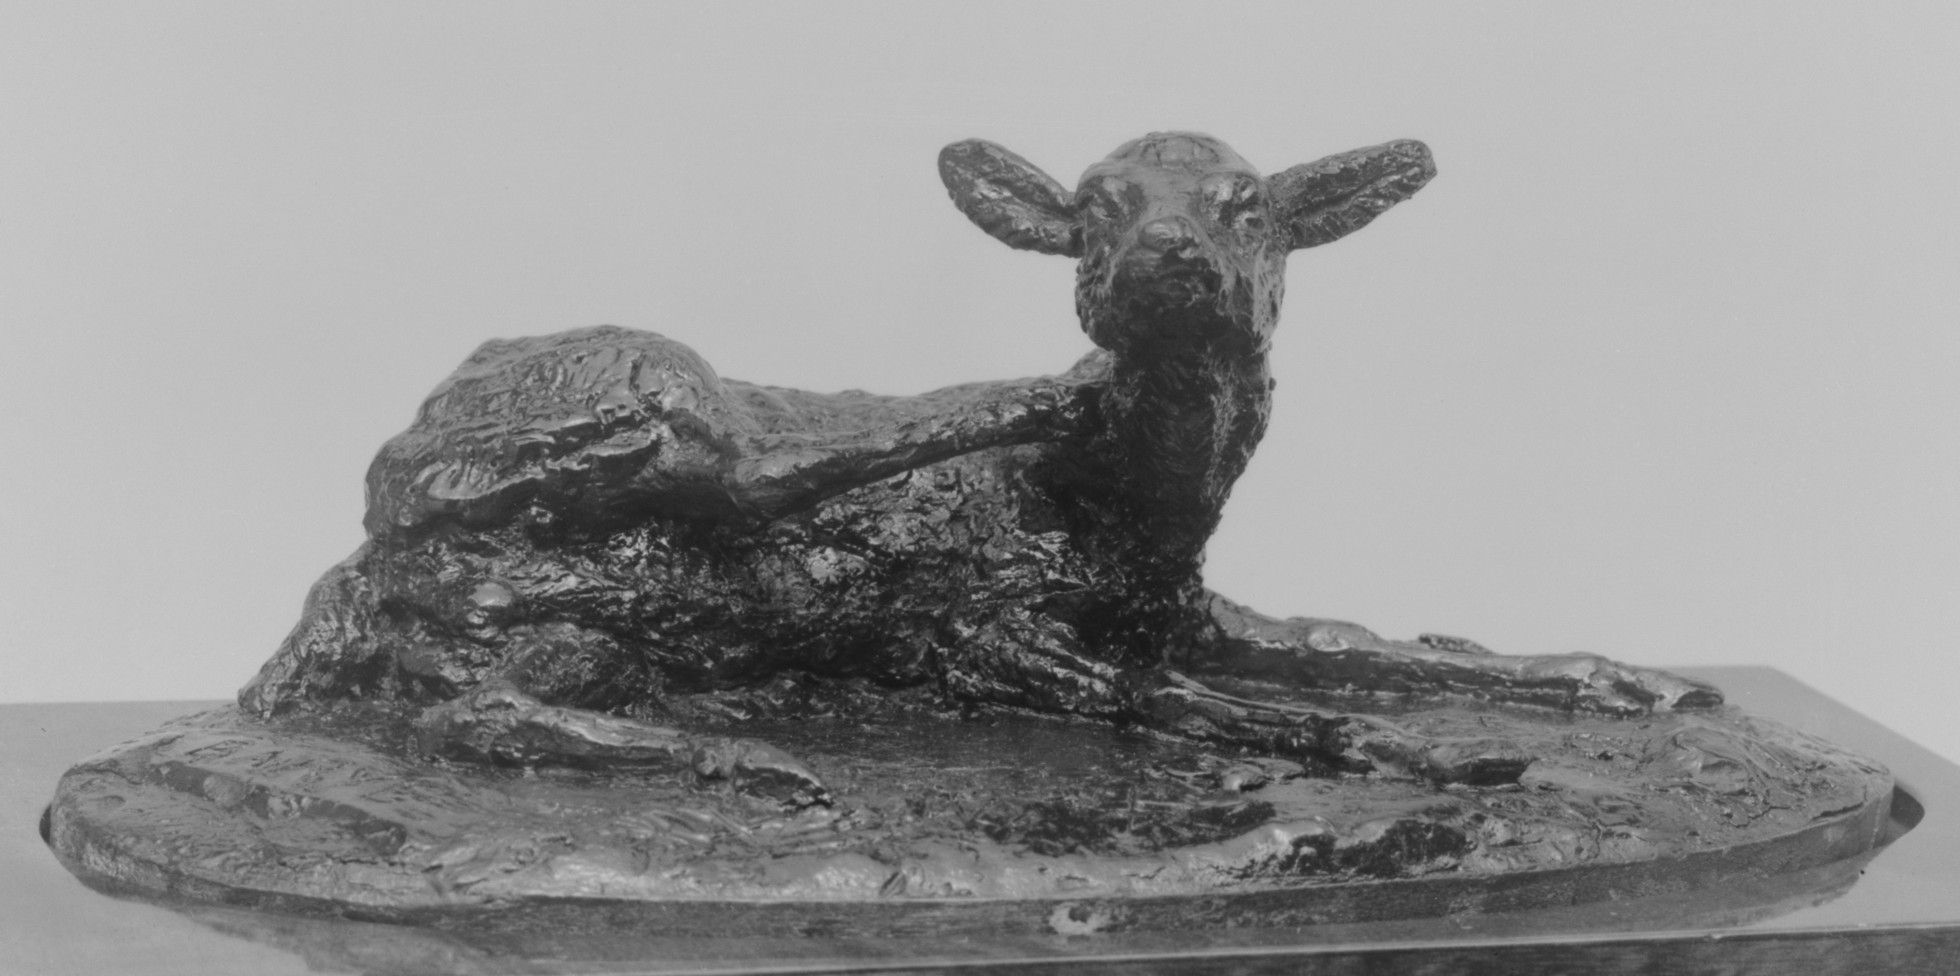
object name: statuette model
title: Fawn Scratching (Faon se grattant)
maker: antoine-louis barye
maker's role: artist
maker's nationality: french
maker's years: 1795-1875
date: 1801-1900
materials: wax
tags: deer